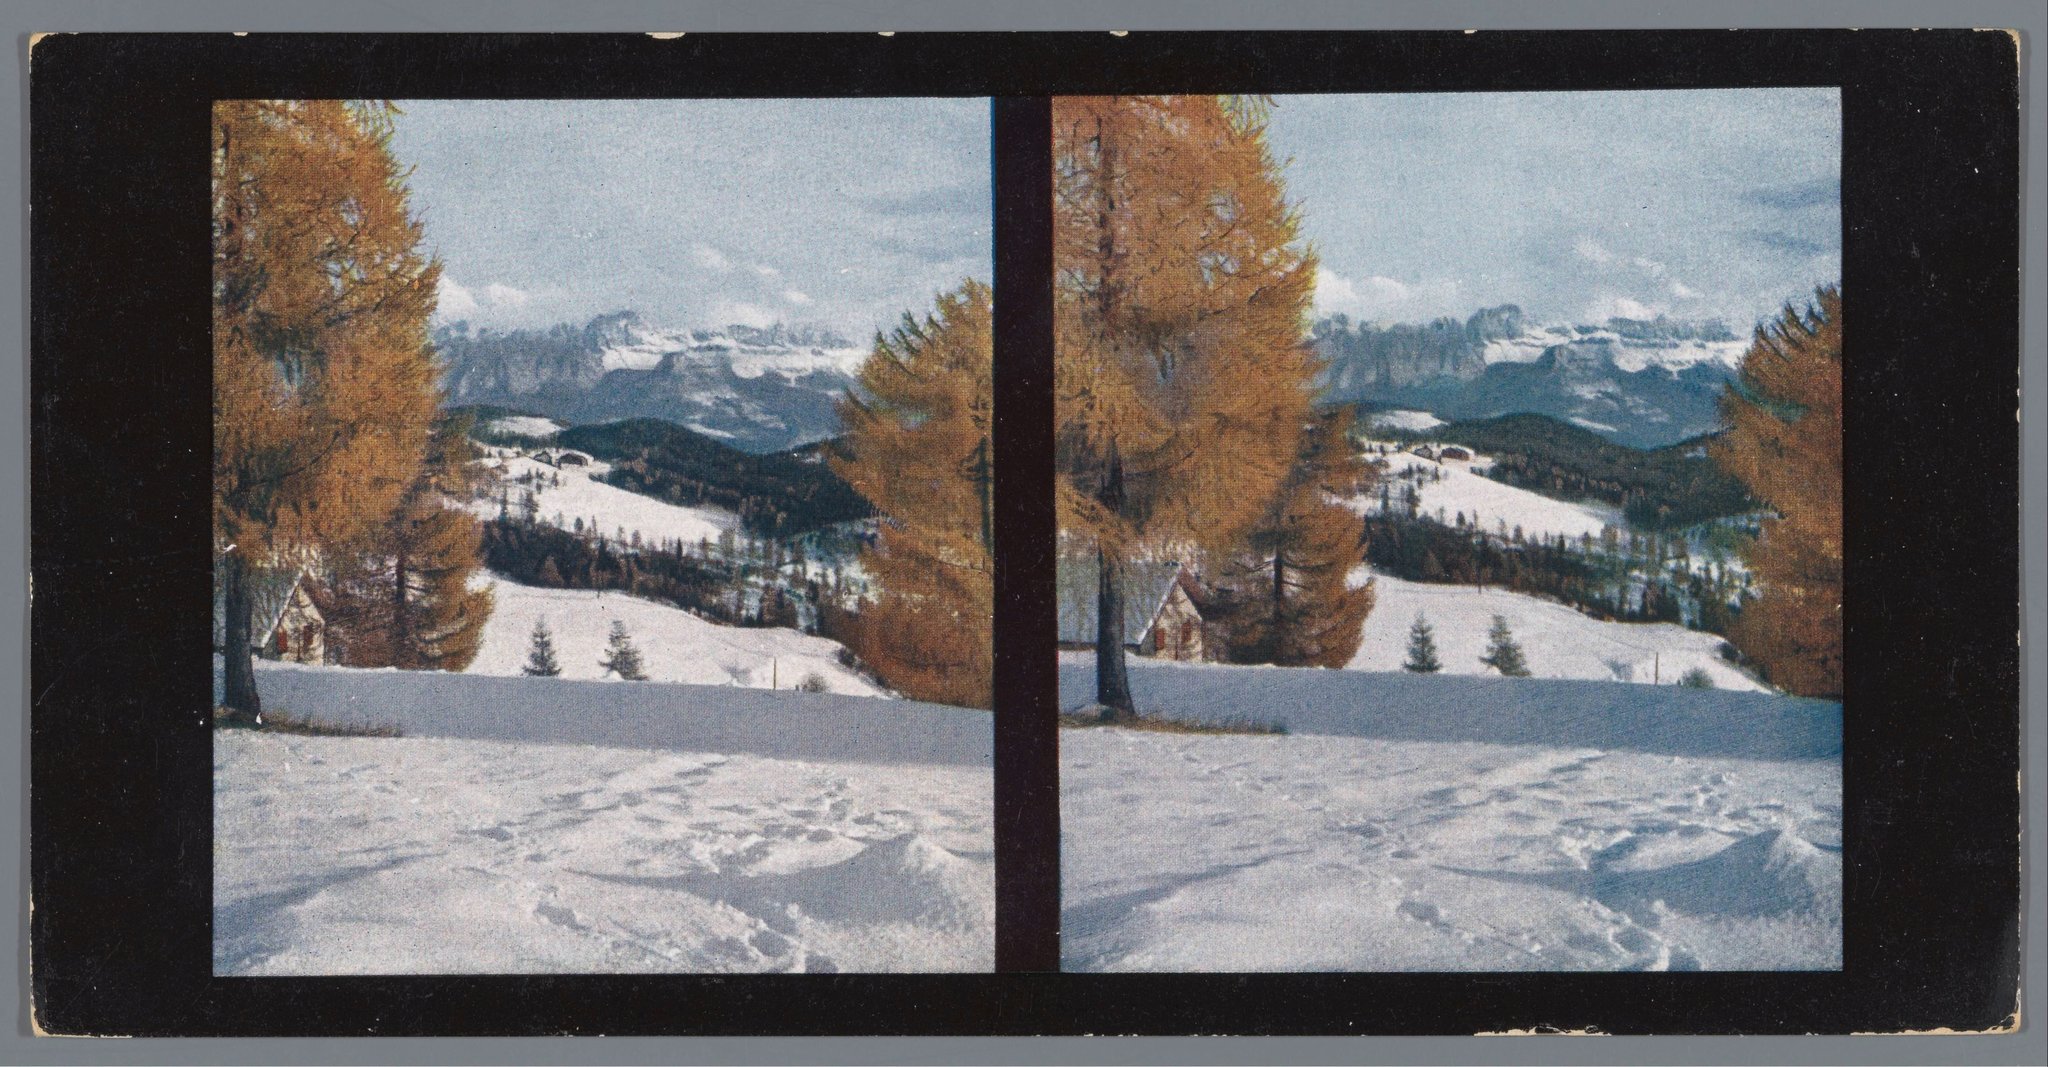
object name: stereograph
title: Blick vom Hohen Ritten (Klobenstein) zum Rosengarten (bei Neuschnee).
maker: hans hildenbrand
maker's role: fotograaf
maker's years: 1870-1957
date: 1902-1908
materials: cardboard, ink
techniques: color autotype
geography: klobenstein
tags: mountains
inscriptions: inscription: ‘D. R. G. M. Nr. 437 756.’, number: ‘Nr. 25.’, inscription: ‘Beste wirkung bei Betrachtung durch das ,,Isostereo''.’, inscription: ‘,,Chromoplast''-Bild.’, inscription: ‘Warenzeichen 142 123.’